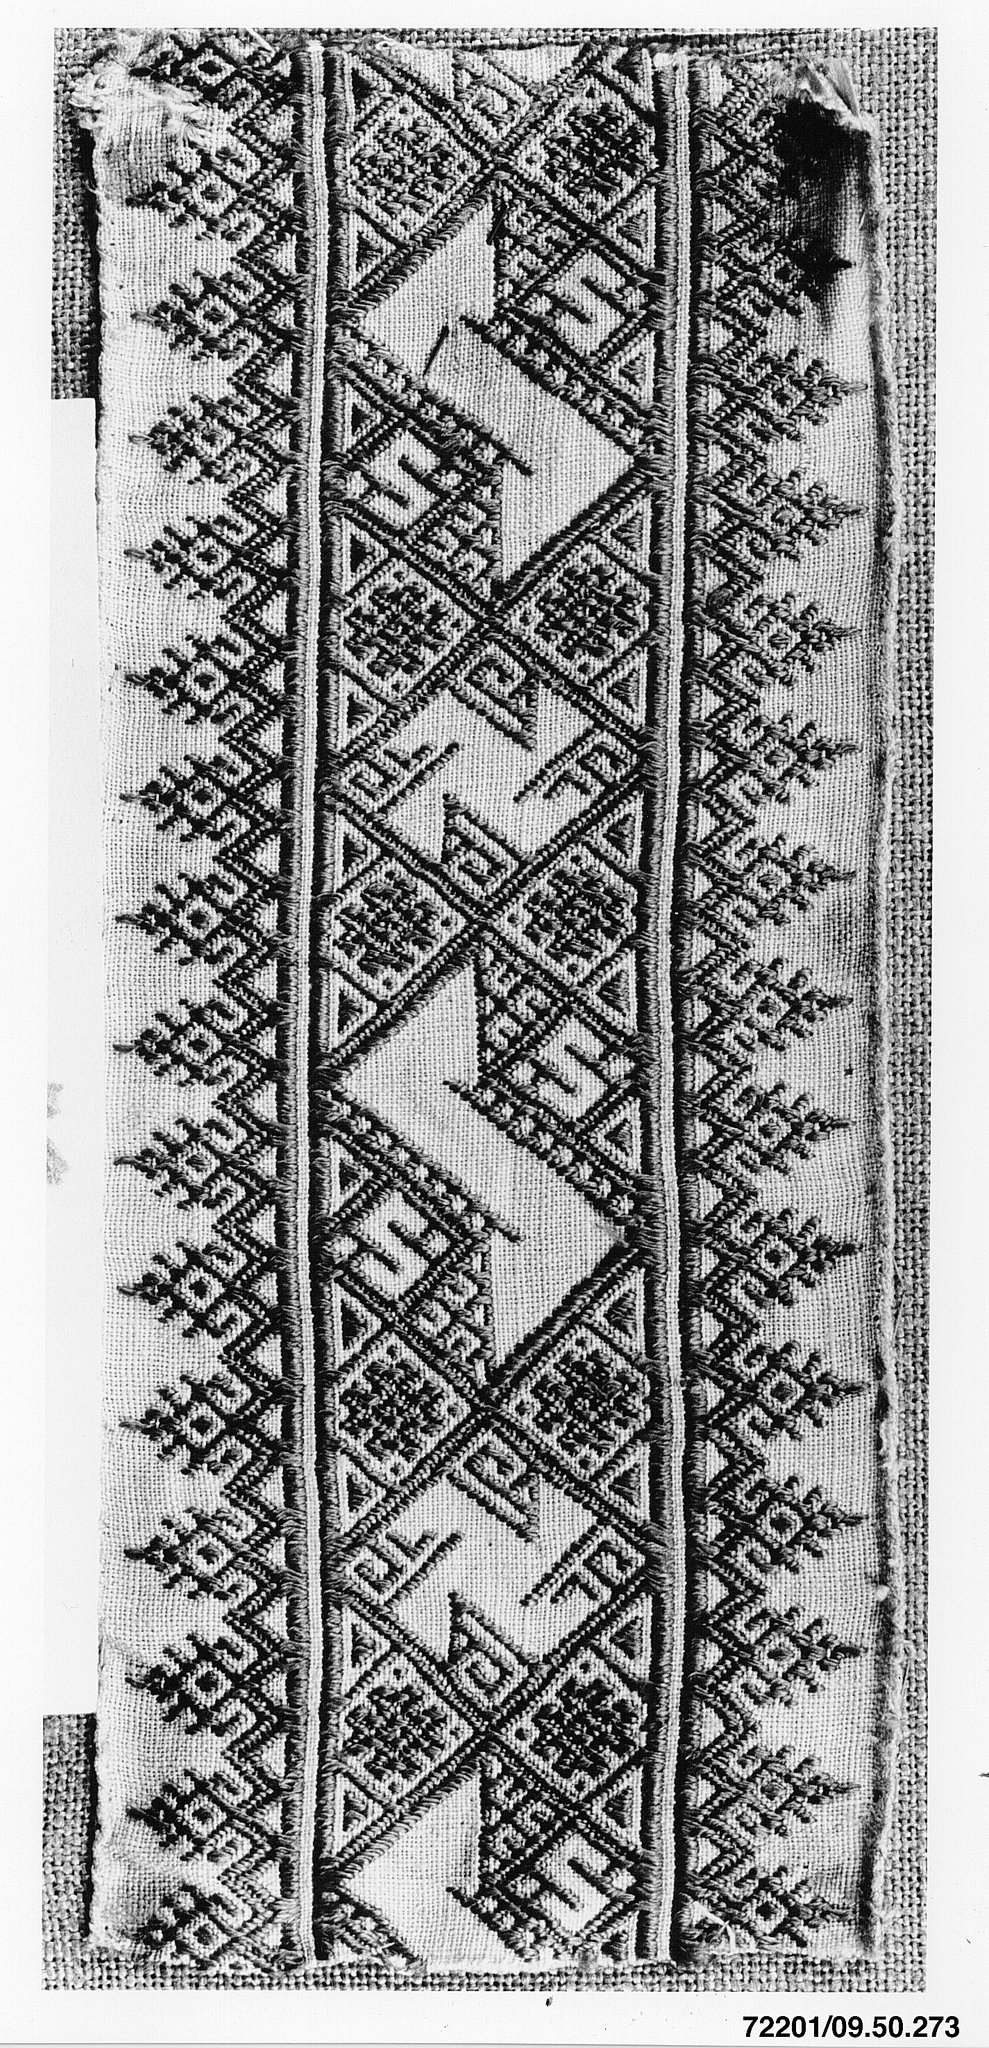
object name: band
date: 1701-1800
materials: linen, silk